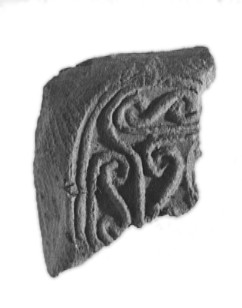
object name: sealing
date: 2030-1640 BCE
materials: clay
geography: egypt